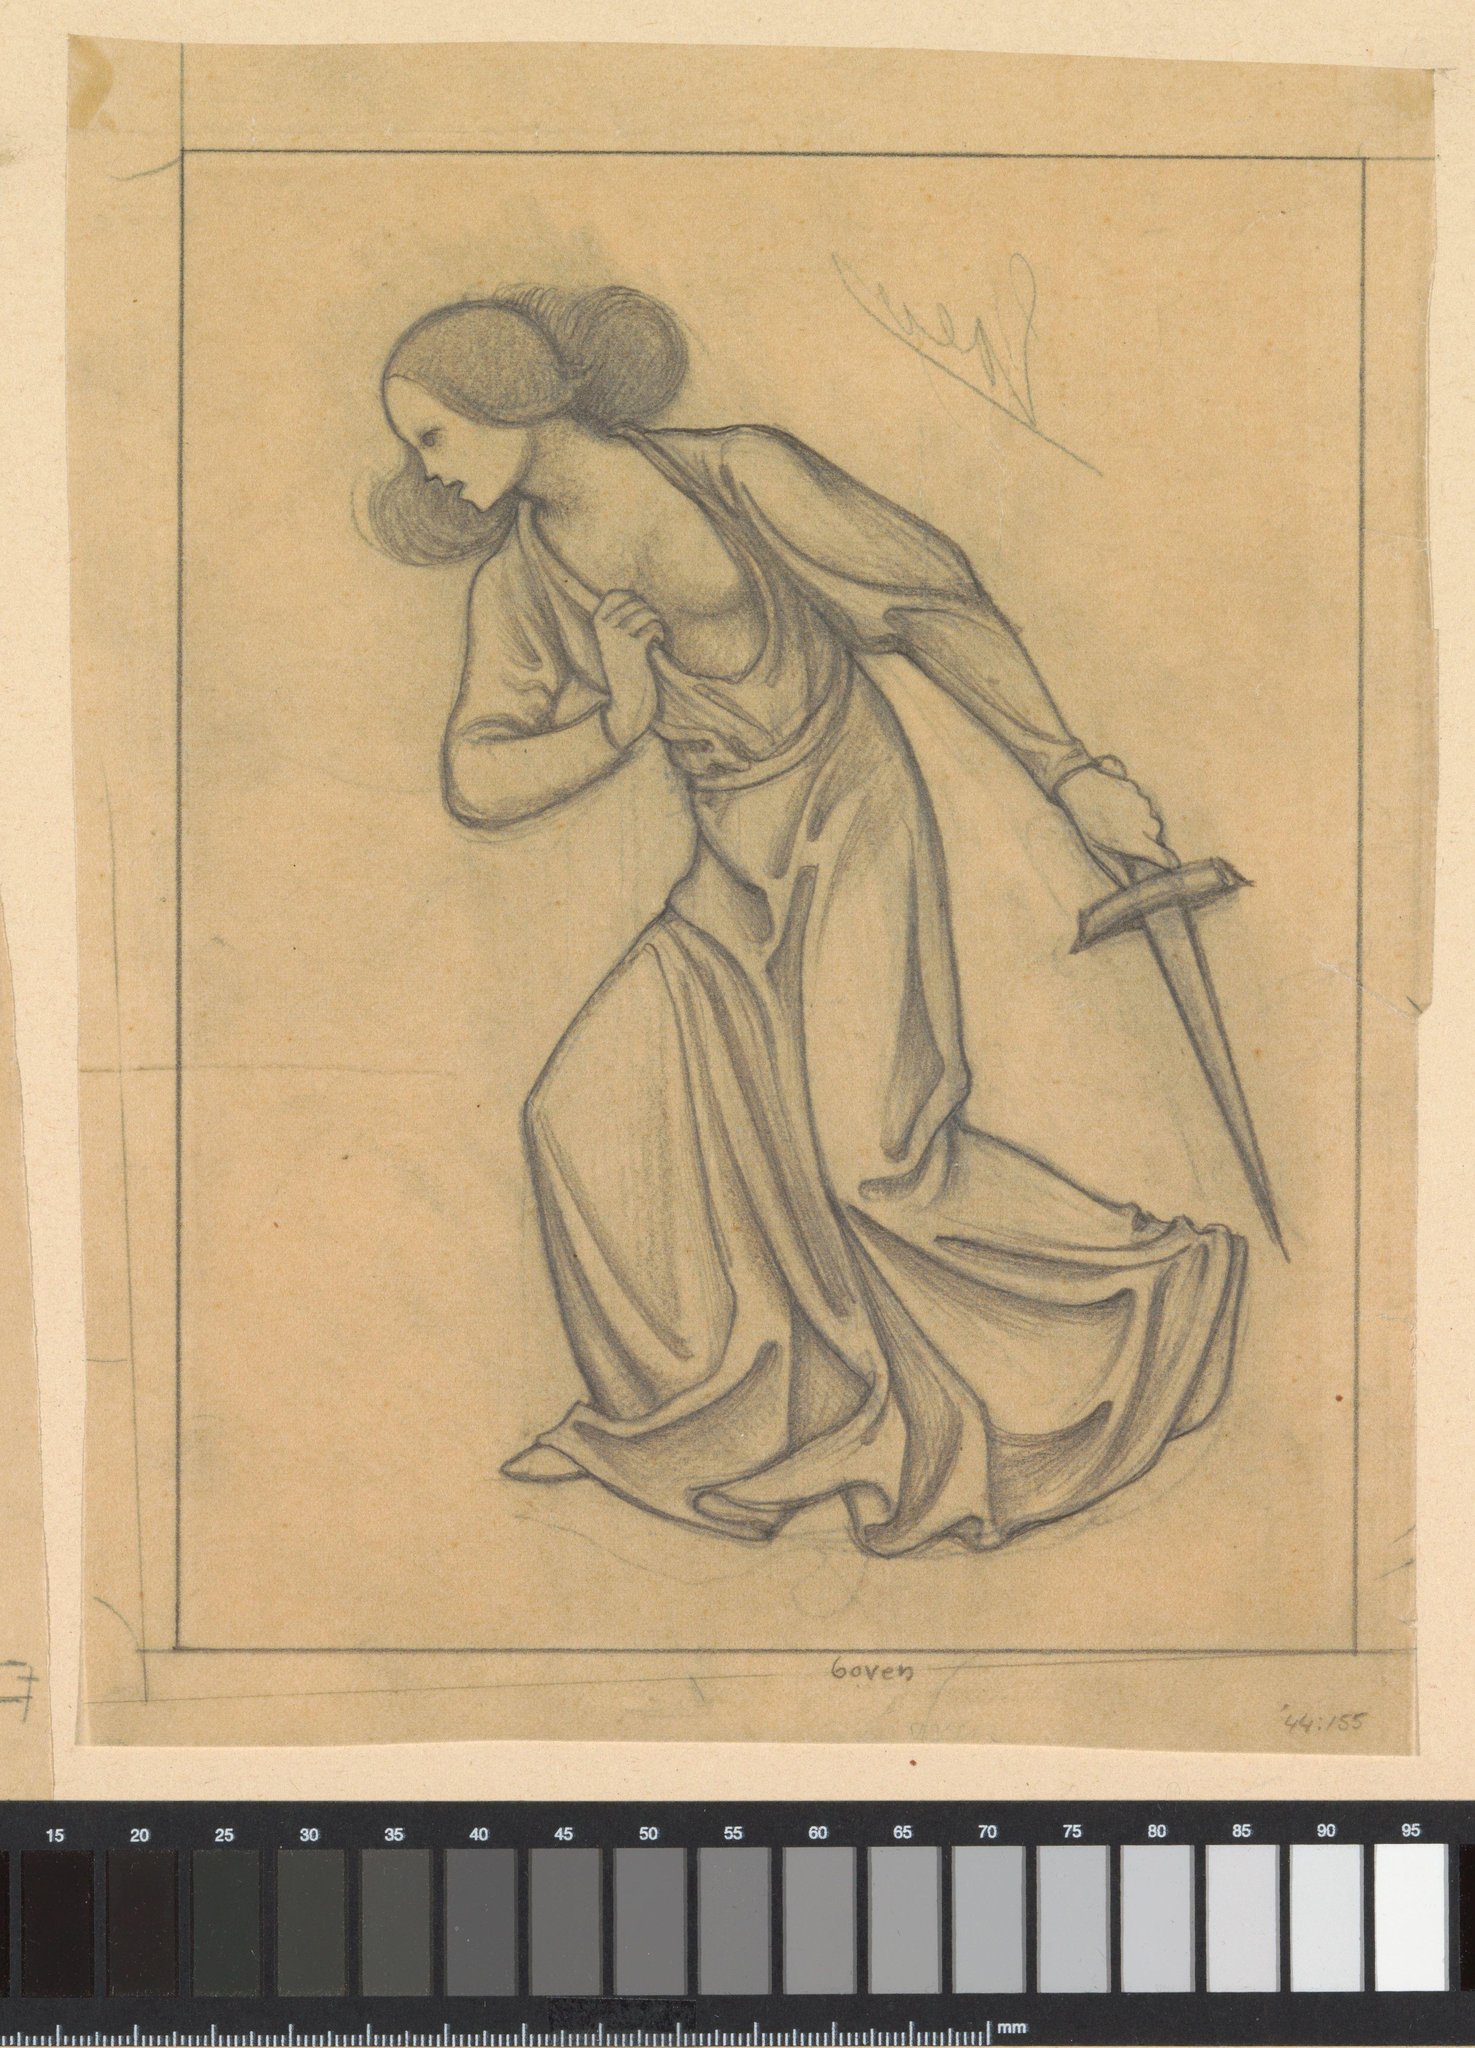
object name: drawing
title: Ontwerp voor wandschildering in de Beurs van Berlage: staande vrouw met getrokken zwaard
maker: antoon derkinderen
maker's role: draughtsman, painter, print maker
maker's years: 1859-1925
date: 1869-1925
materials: pencil, paper